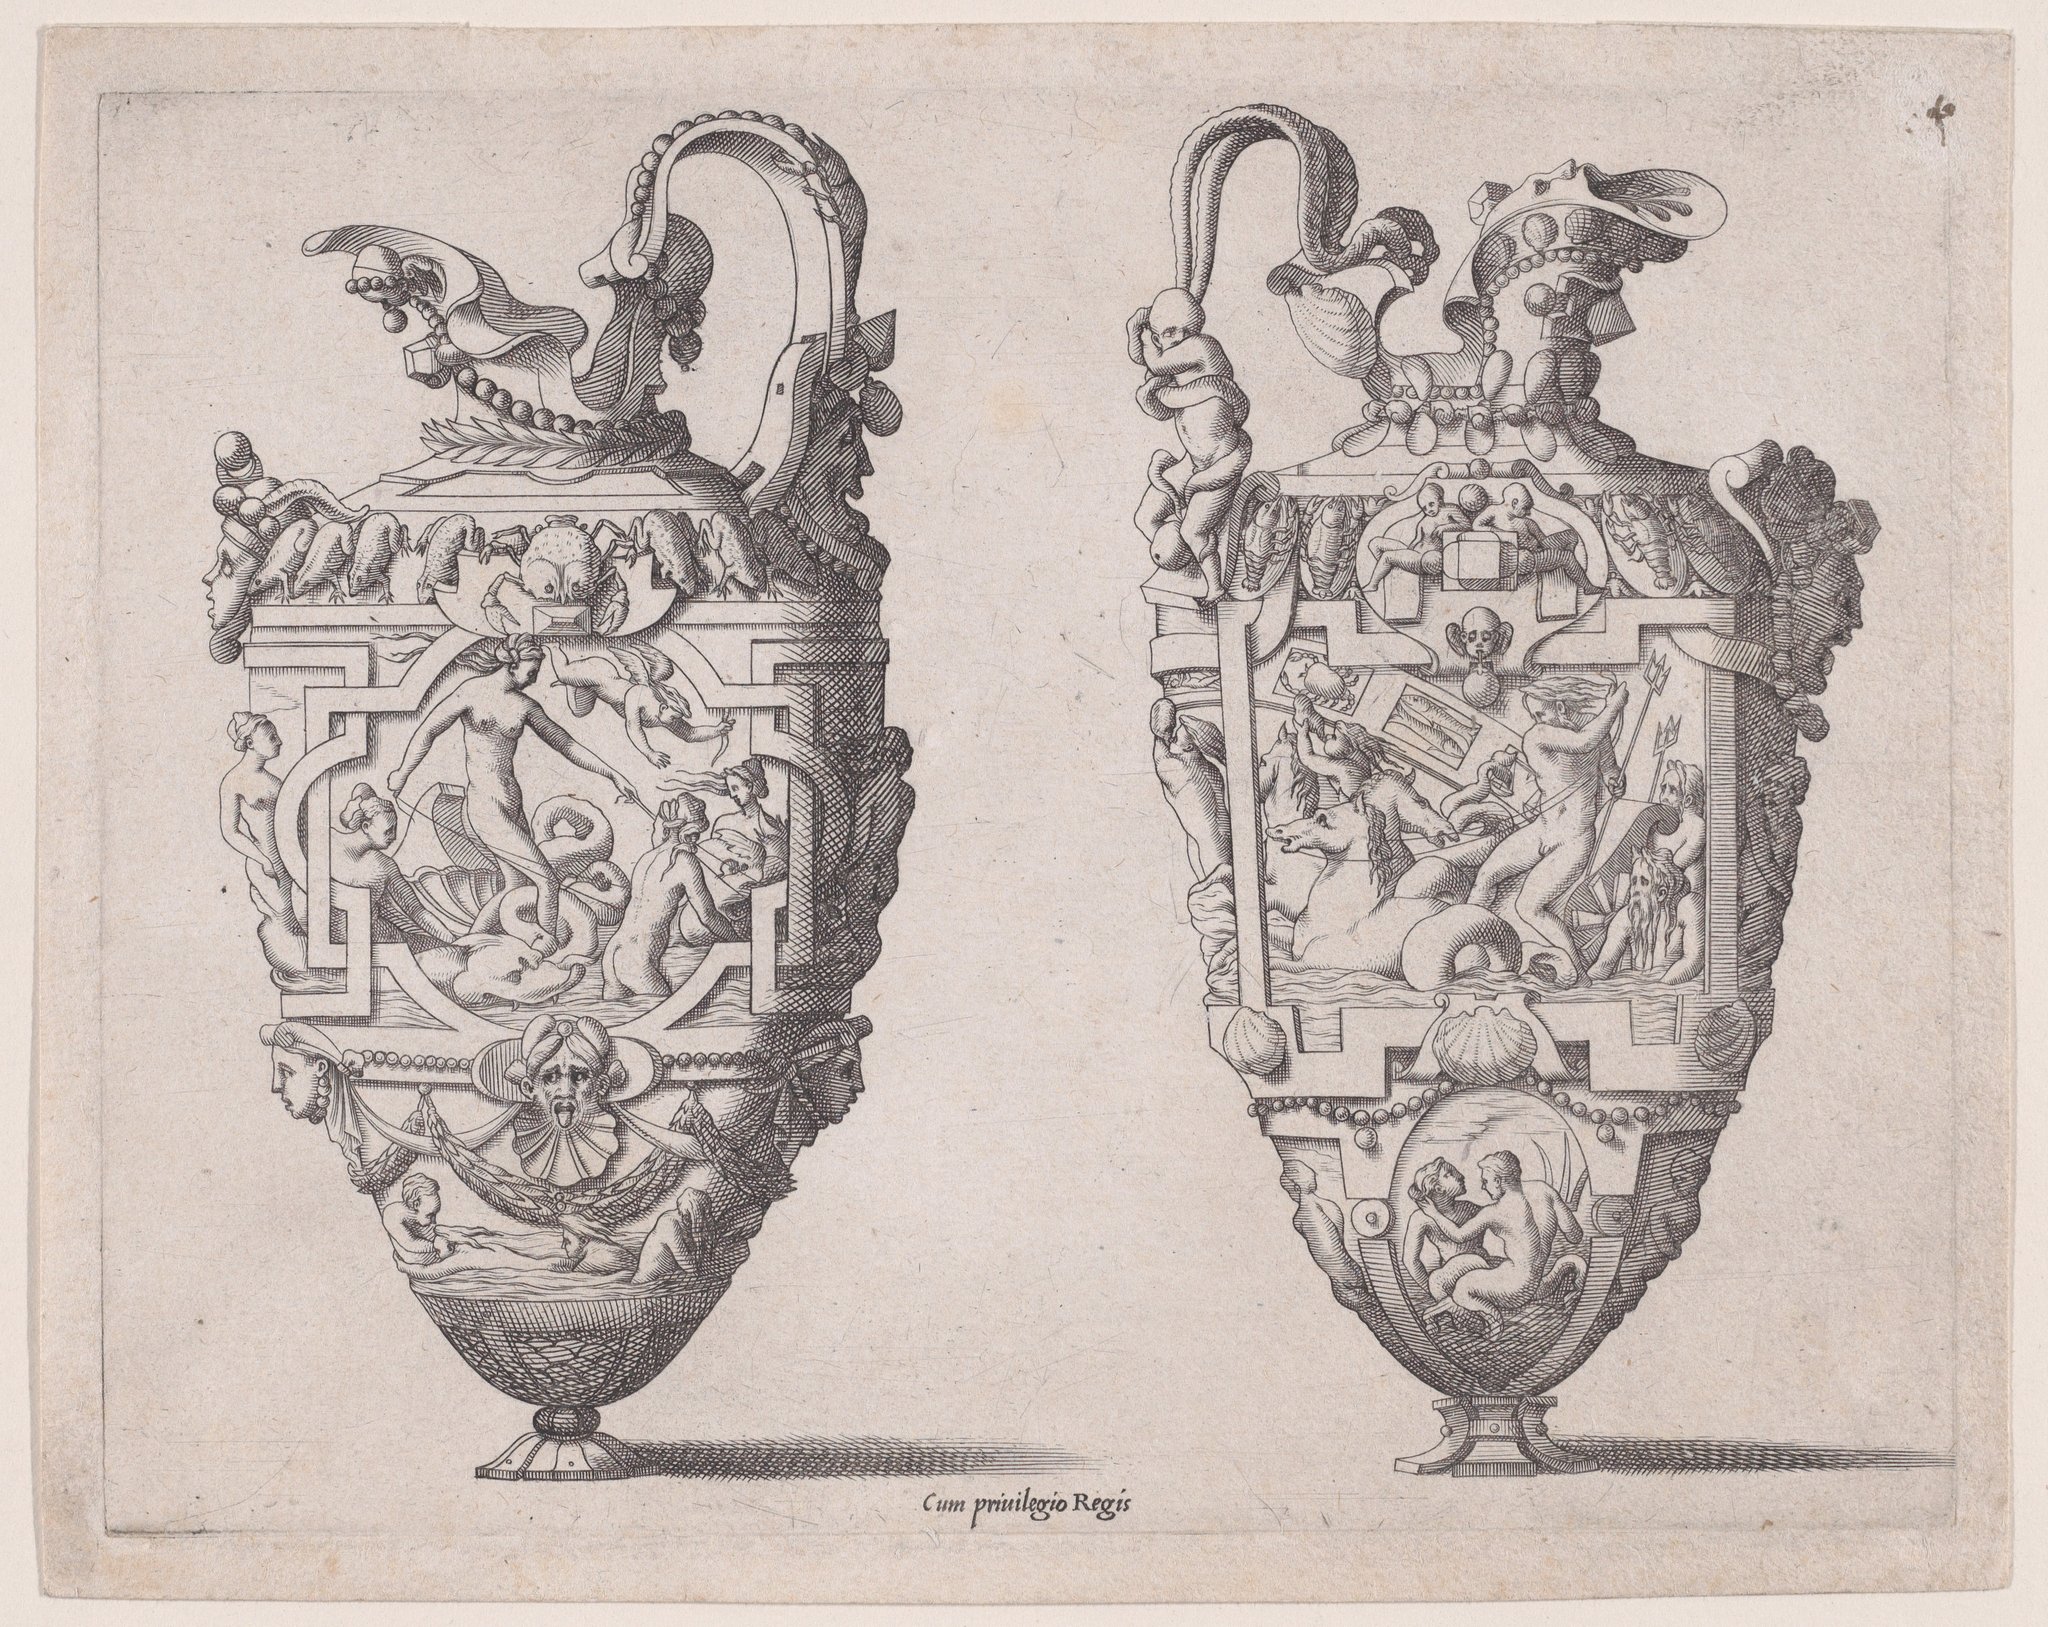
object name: print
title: Two Ewers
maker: rené boyvin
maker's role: artist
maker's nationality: french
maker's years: 1525-1598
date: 1525-1600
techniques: engraving